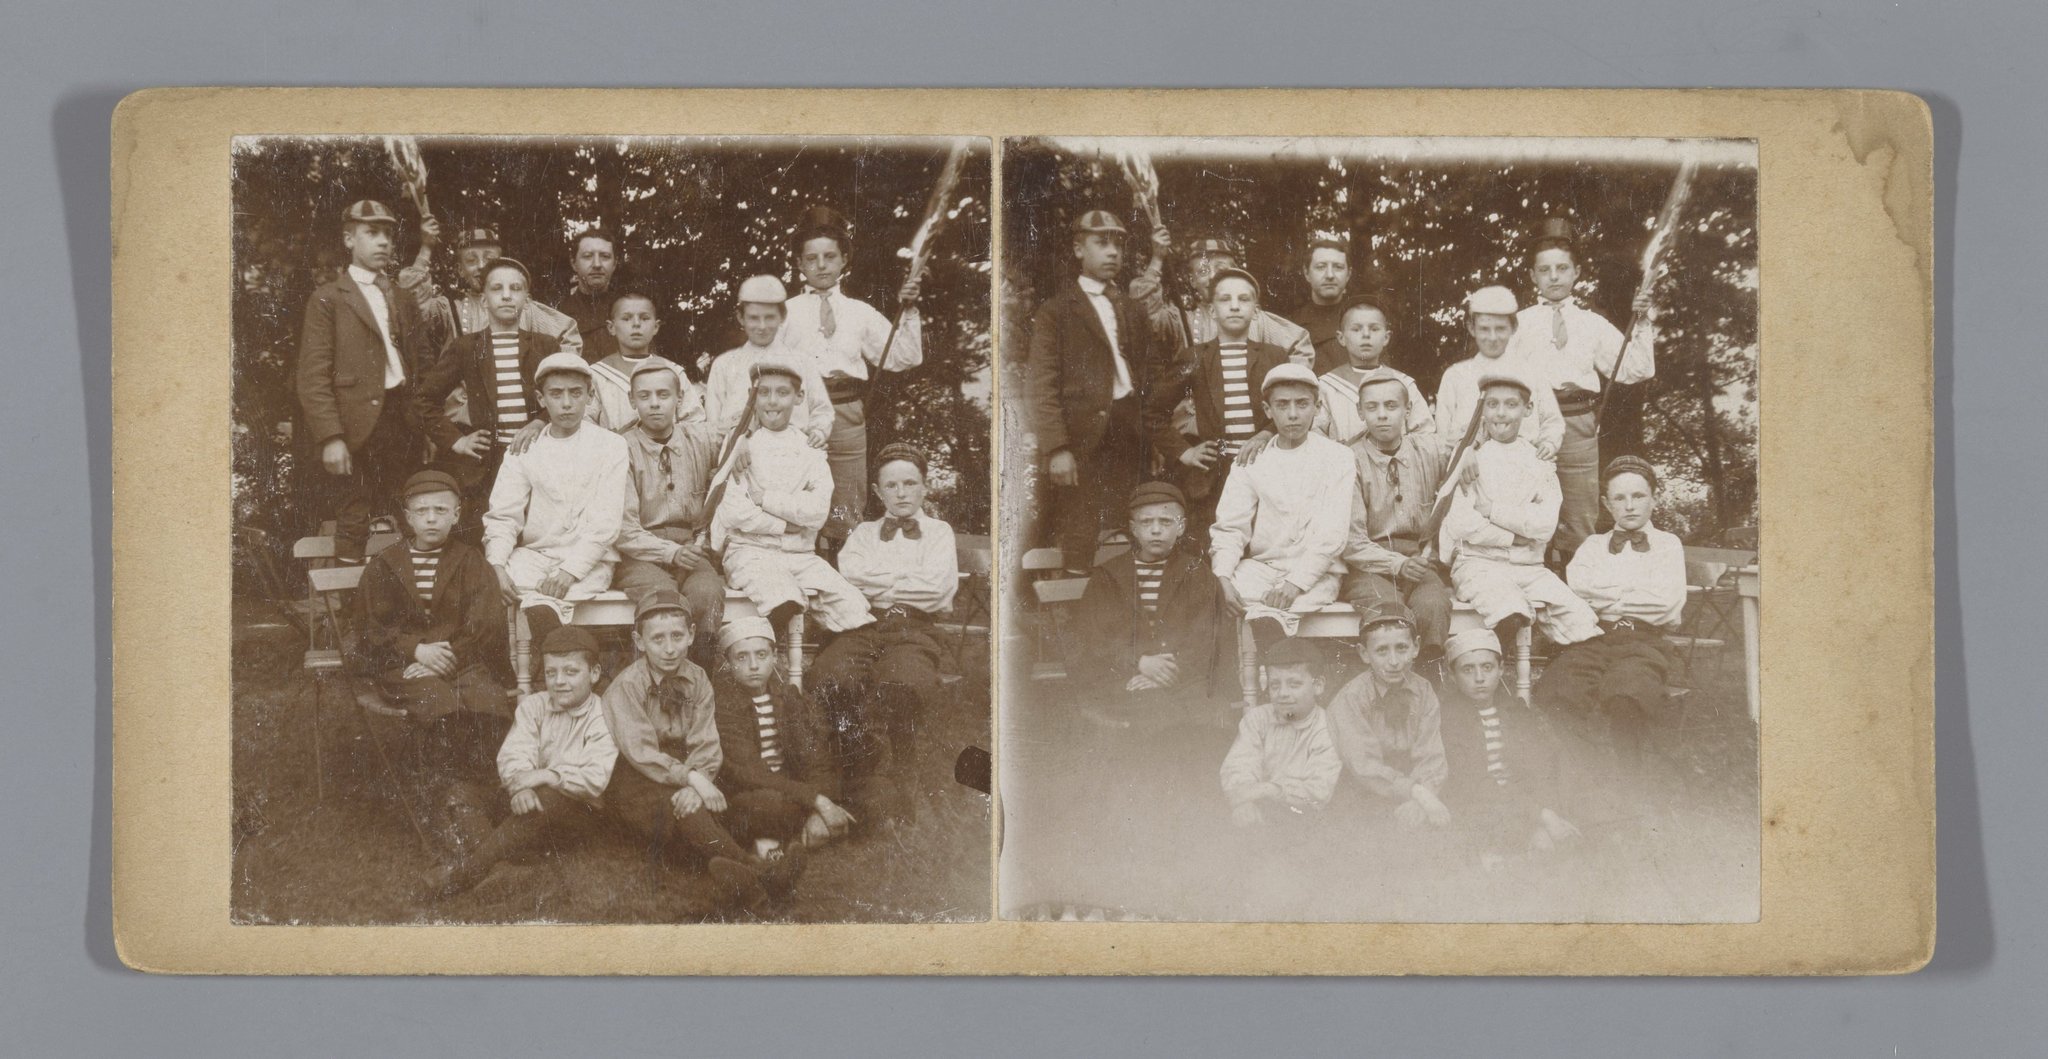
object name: stereograph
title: Portret van een groep onbekende jongens in welpenkostuum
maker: Anonymous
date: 1850-1920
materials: cardboard, photographic support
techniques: daylight paper print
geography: europe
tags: boy (child between toddler and youth), europe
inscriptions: number: ‘23’